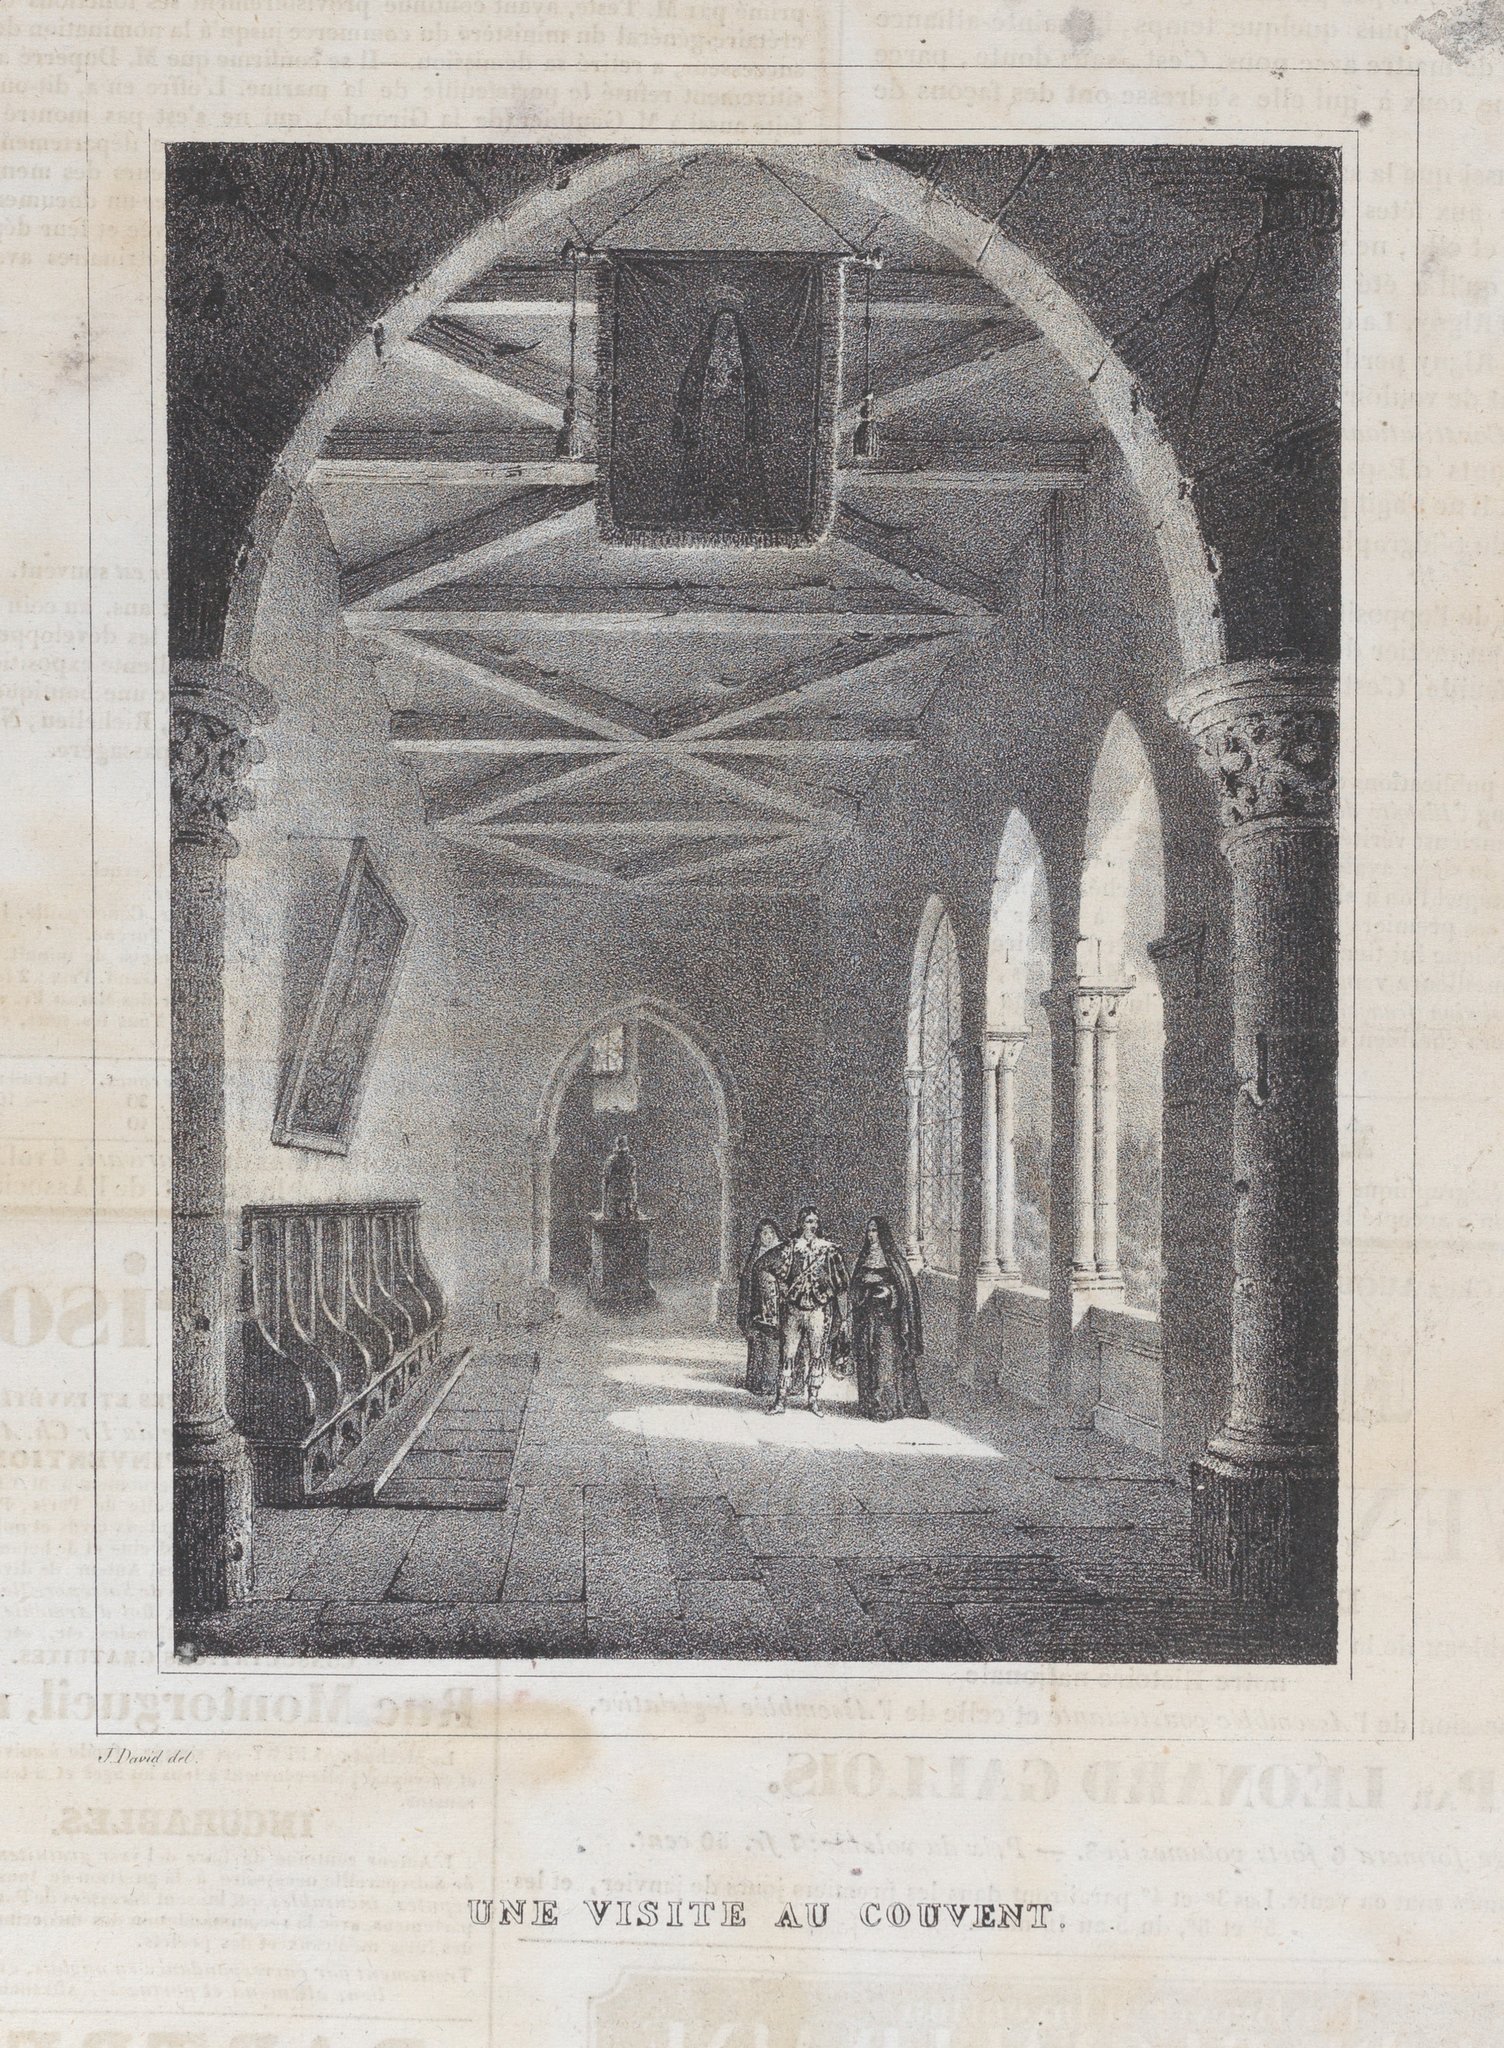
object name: print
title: Une Visite au Couvent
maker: Anonymous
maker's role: artist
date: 1834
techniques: lithograph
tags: interiors,men,nuns